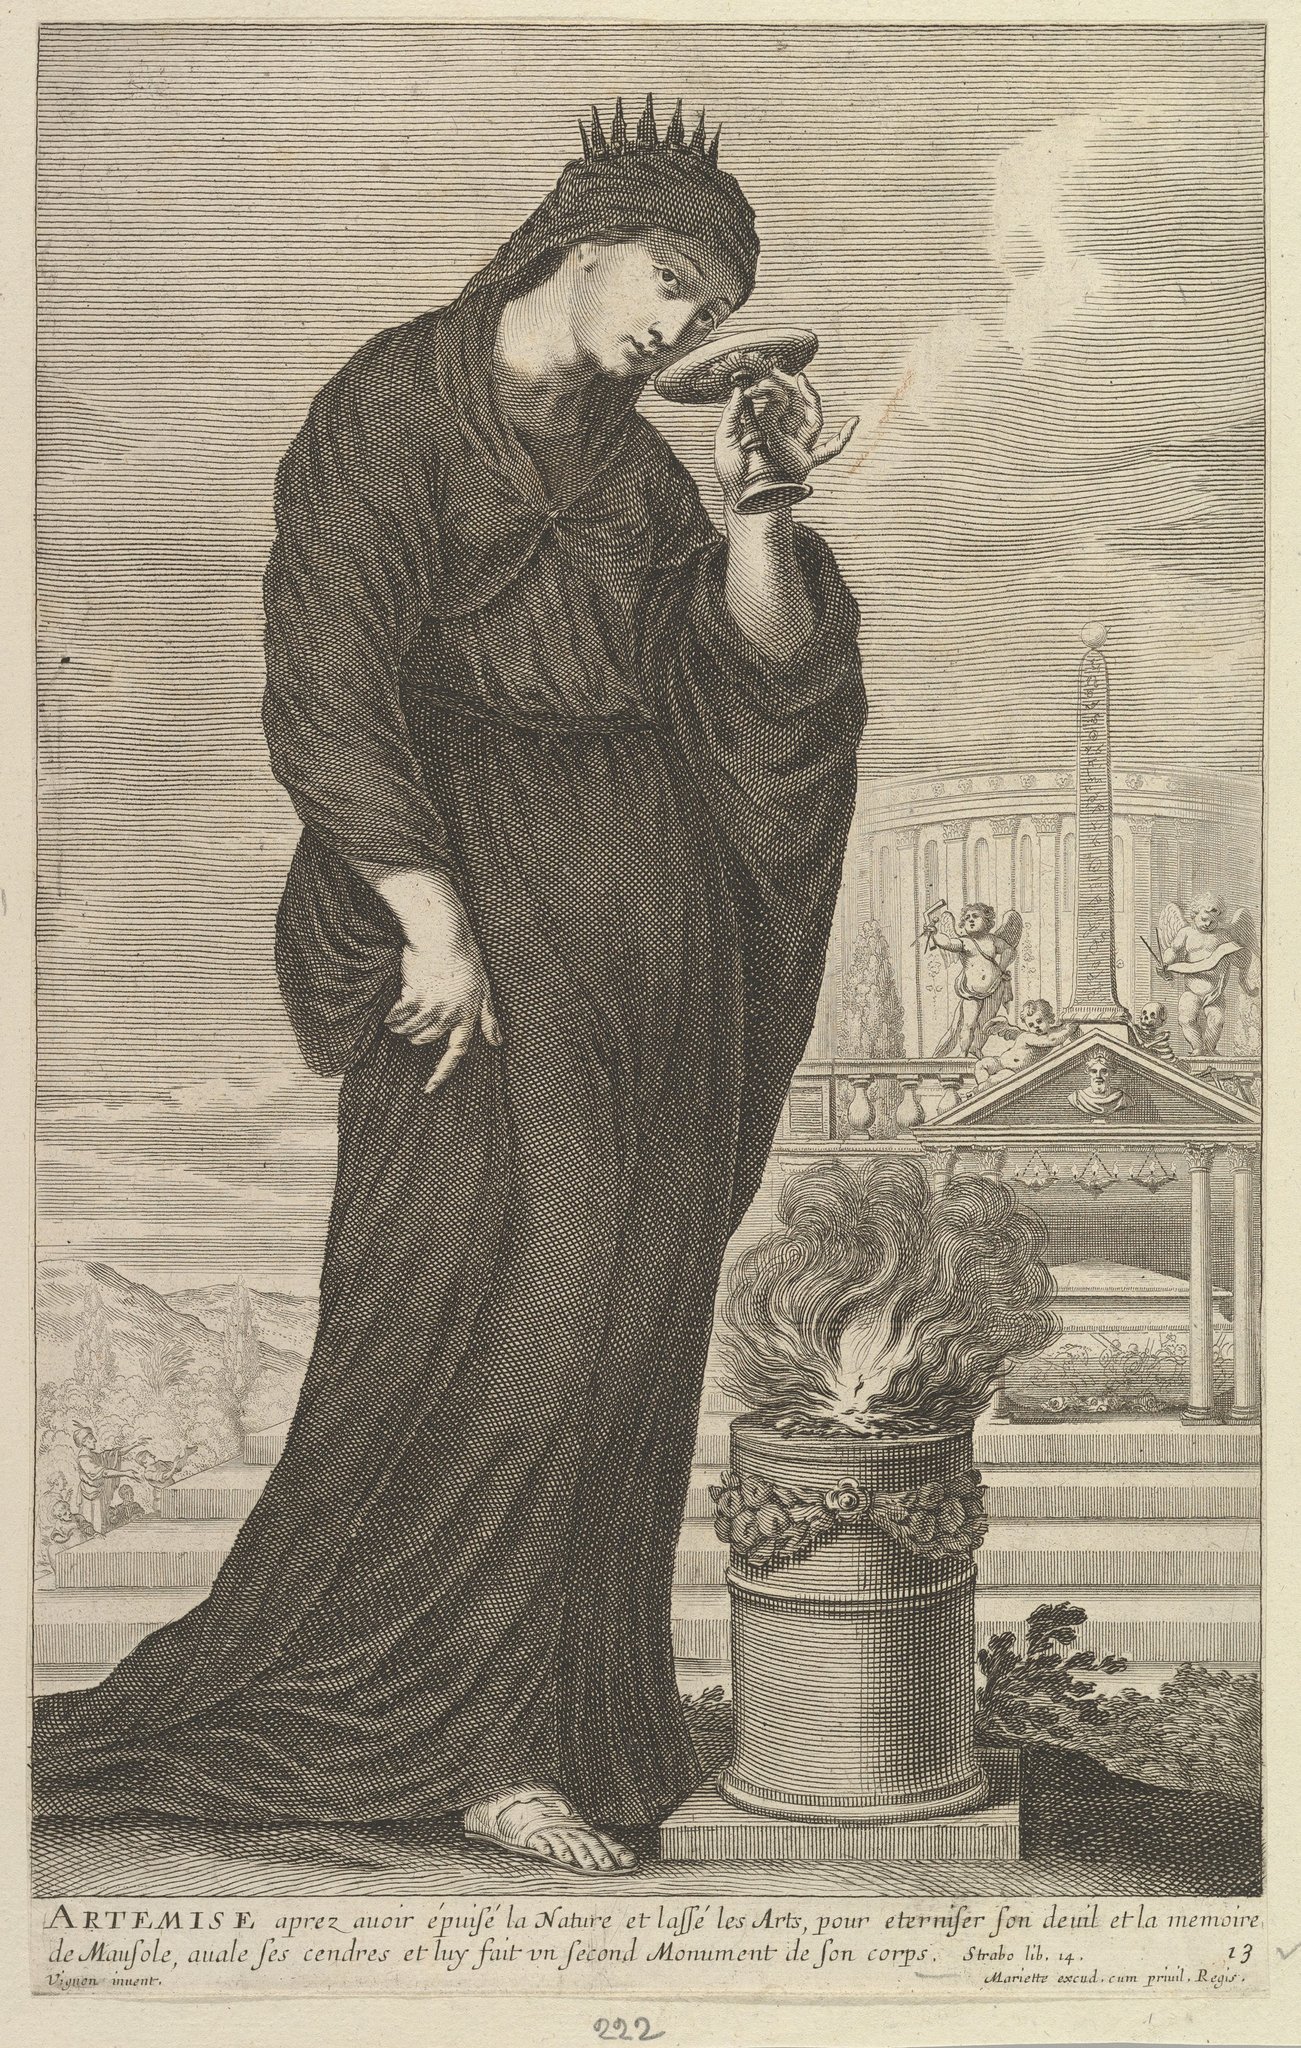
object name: print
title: Artémise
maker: gilles rousselet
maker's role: artist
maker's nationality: french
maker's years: 1614-1686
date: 1647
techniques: engraving, etching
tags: women